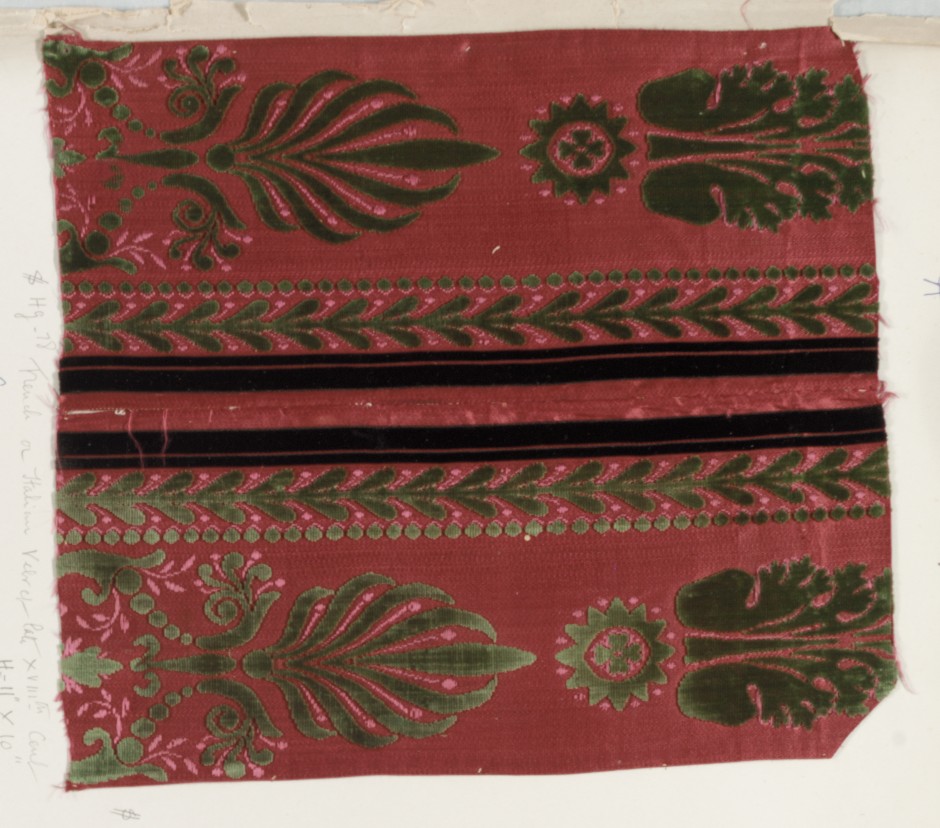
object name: fragment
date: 1767-1800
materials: silk